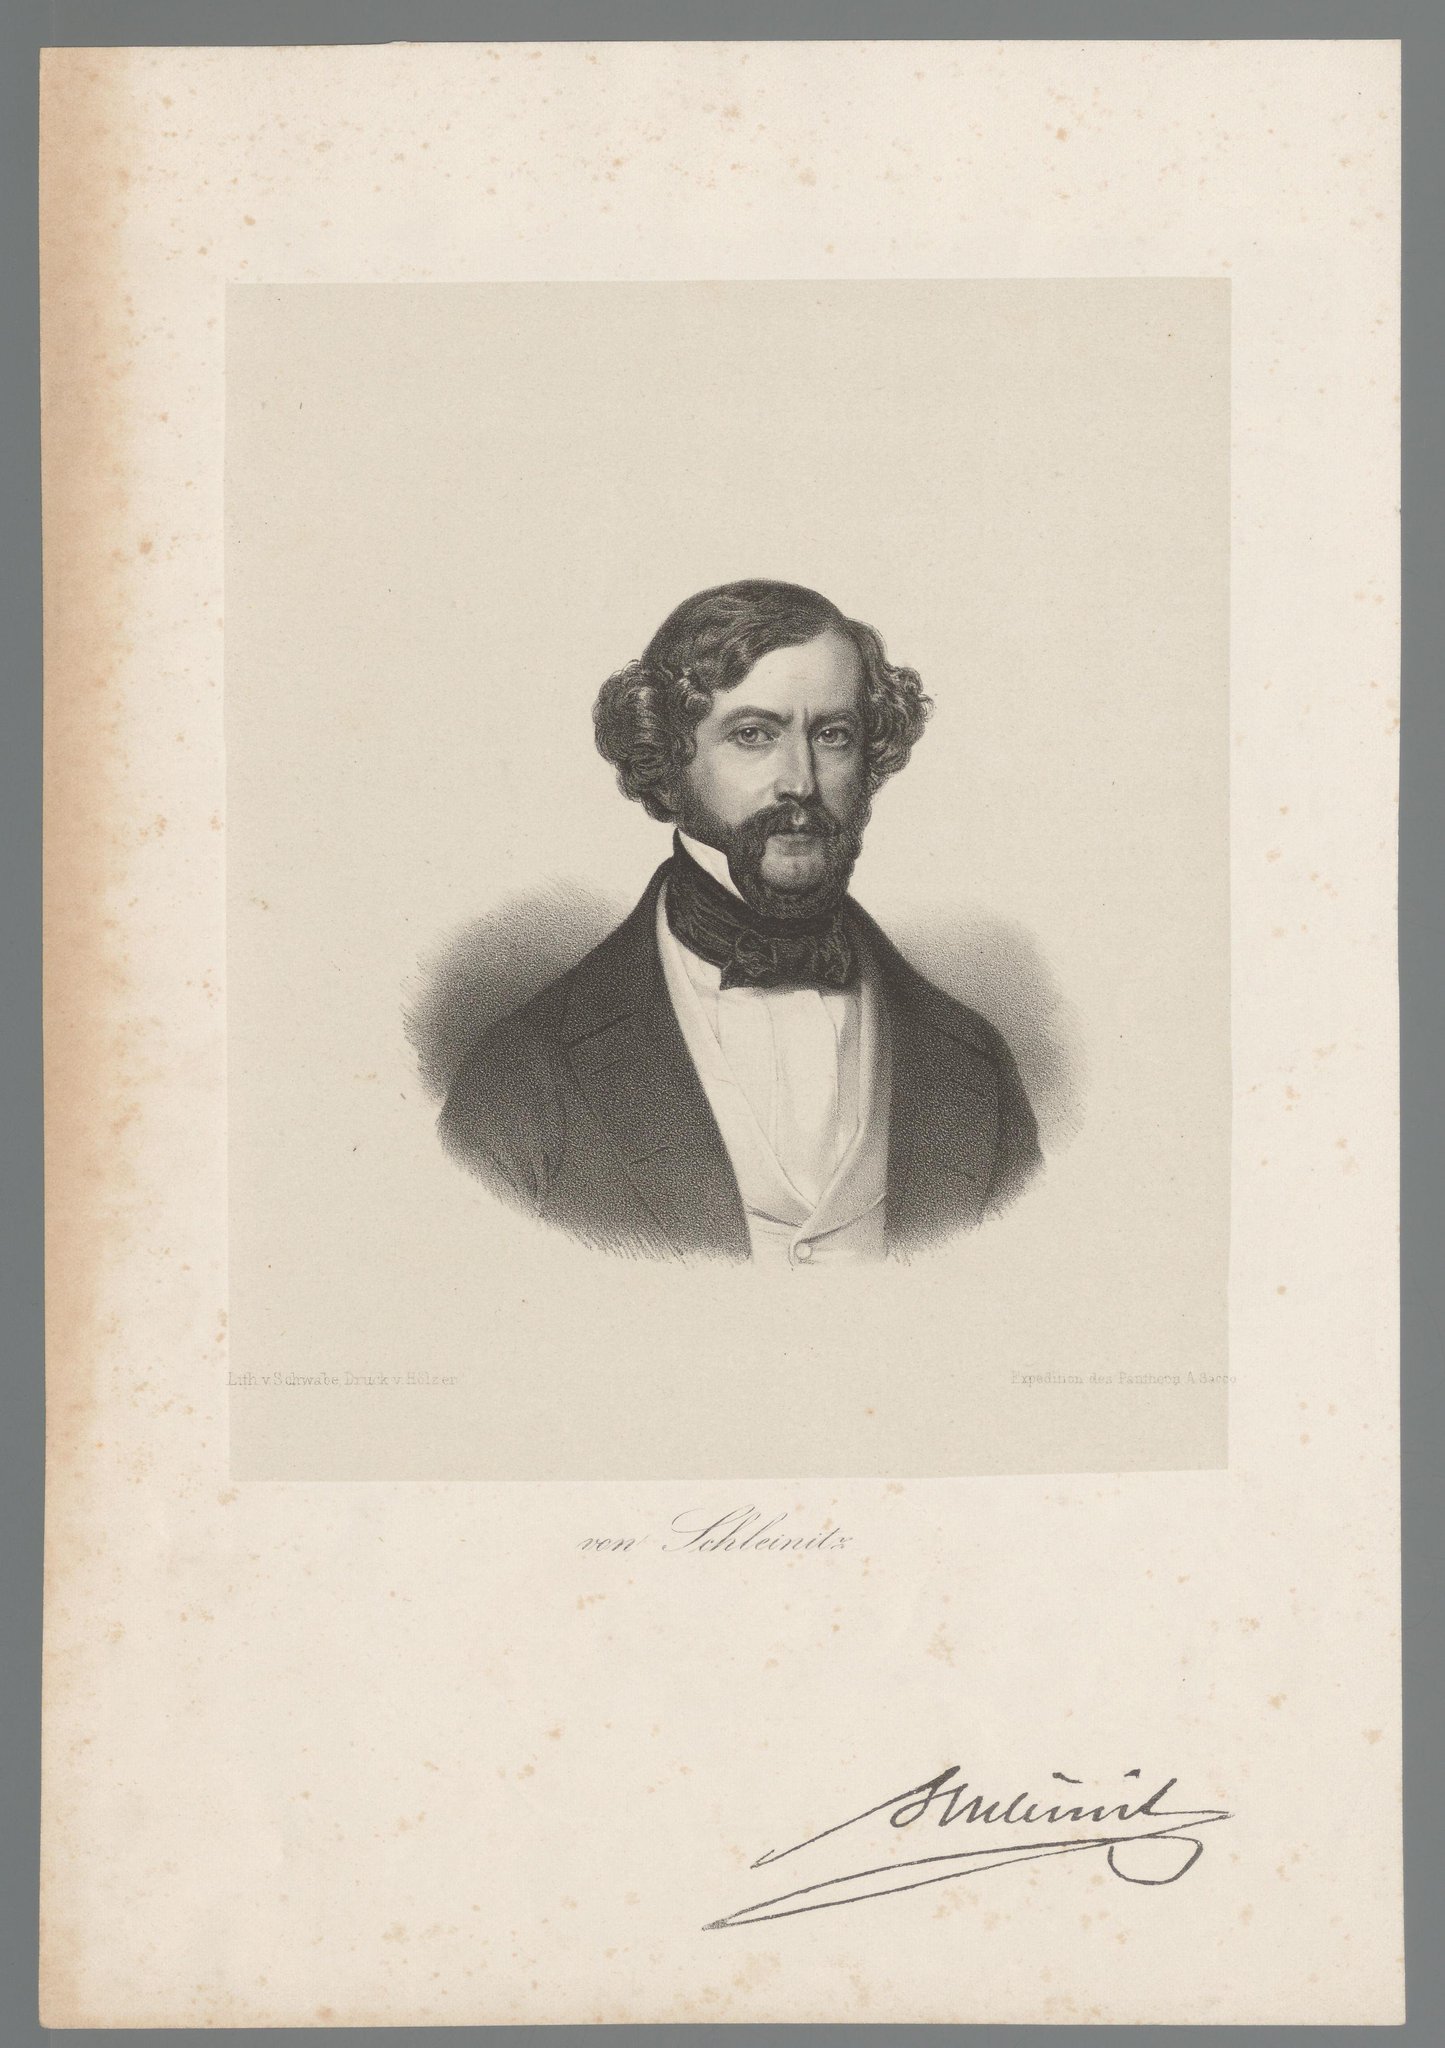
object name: print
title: Von Schleinitz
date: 1830-1863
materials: paper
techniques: lithograph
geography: berlin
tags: adult man, historical persons, beard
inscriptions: collector's mark: Lugt 2228